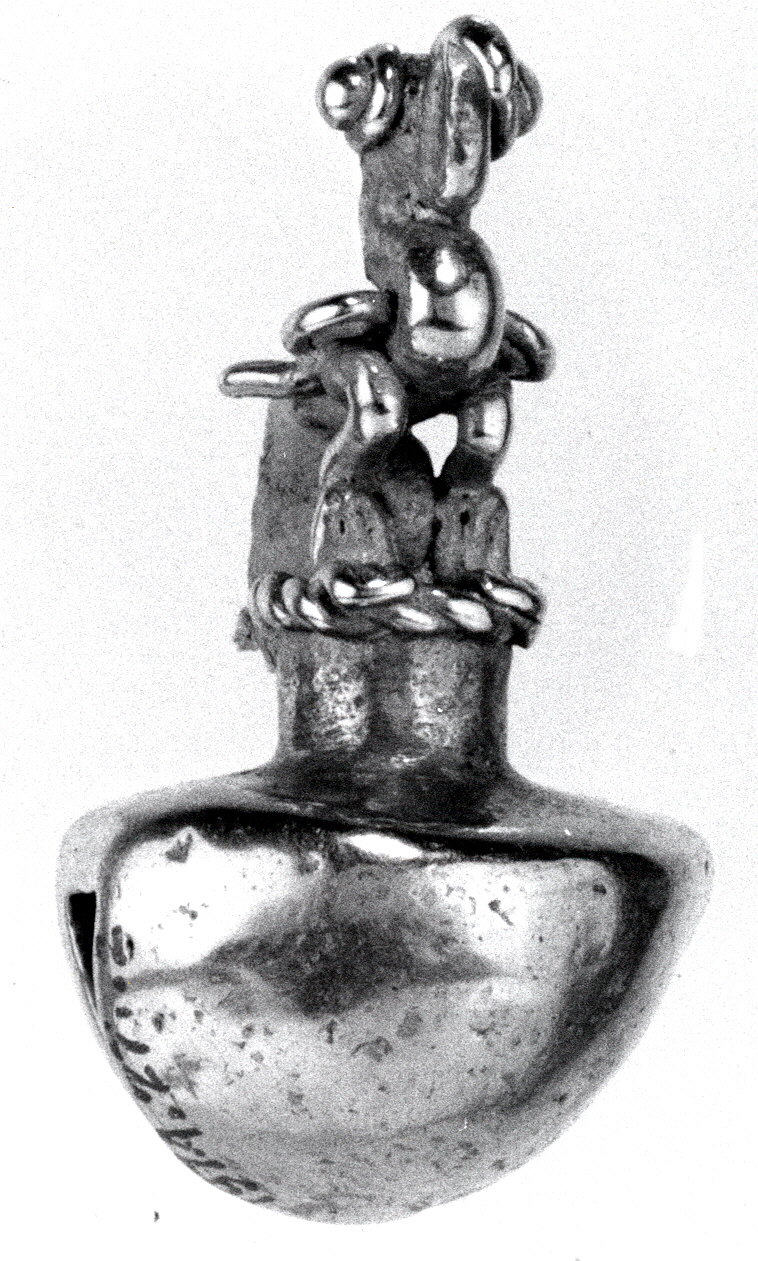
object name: pendant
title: Bell Pendant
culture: greater chiriquí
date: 900-1520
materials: gold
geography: panama